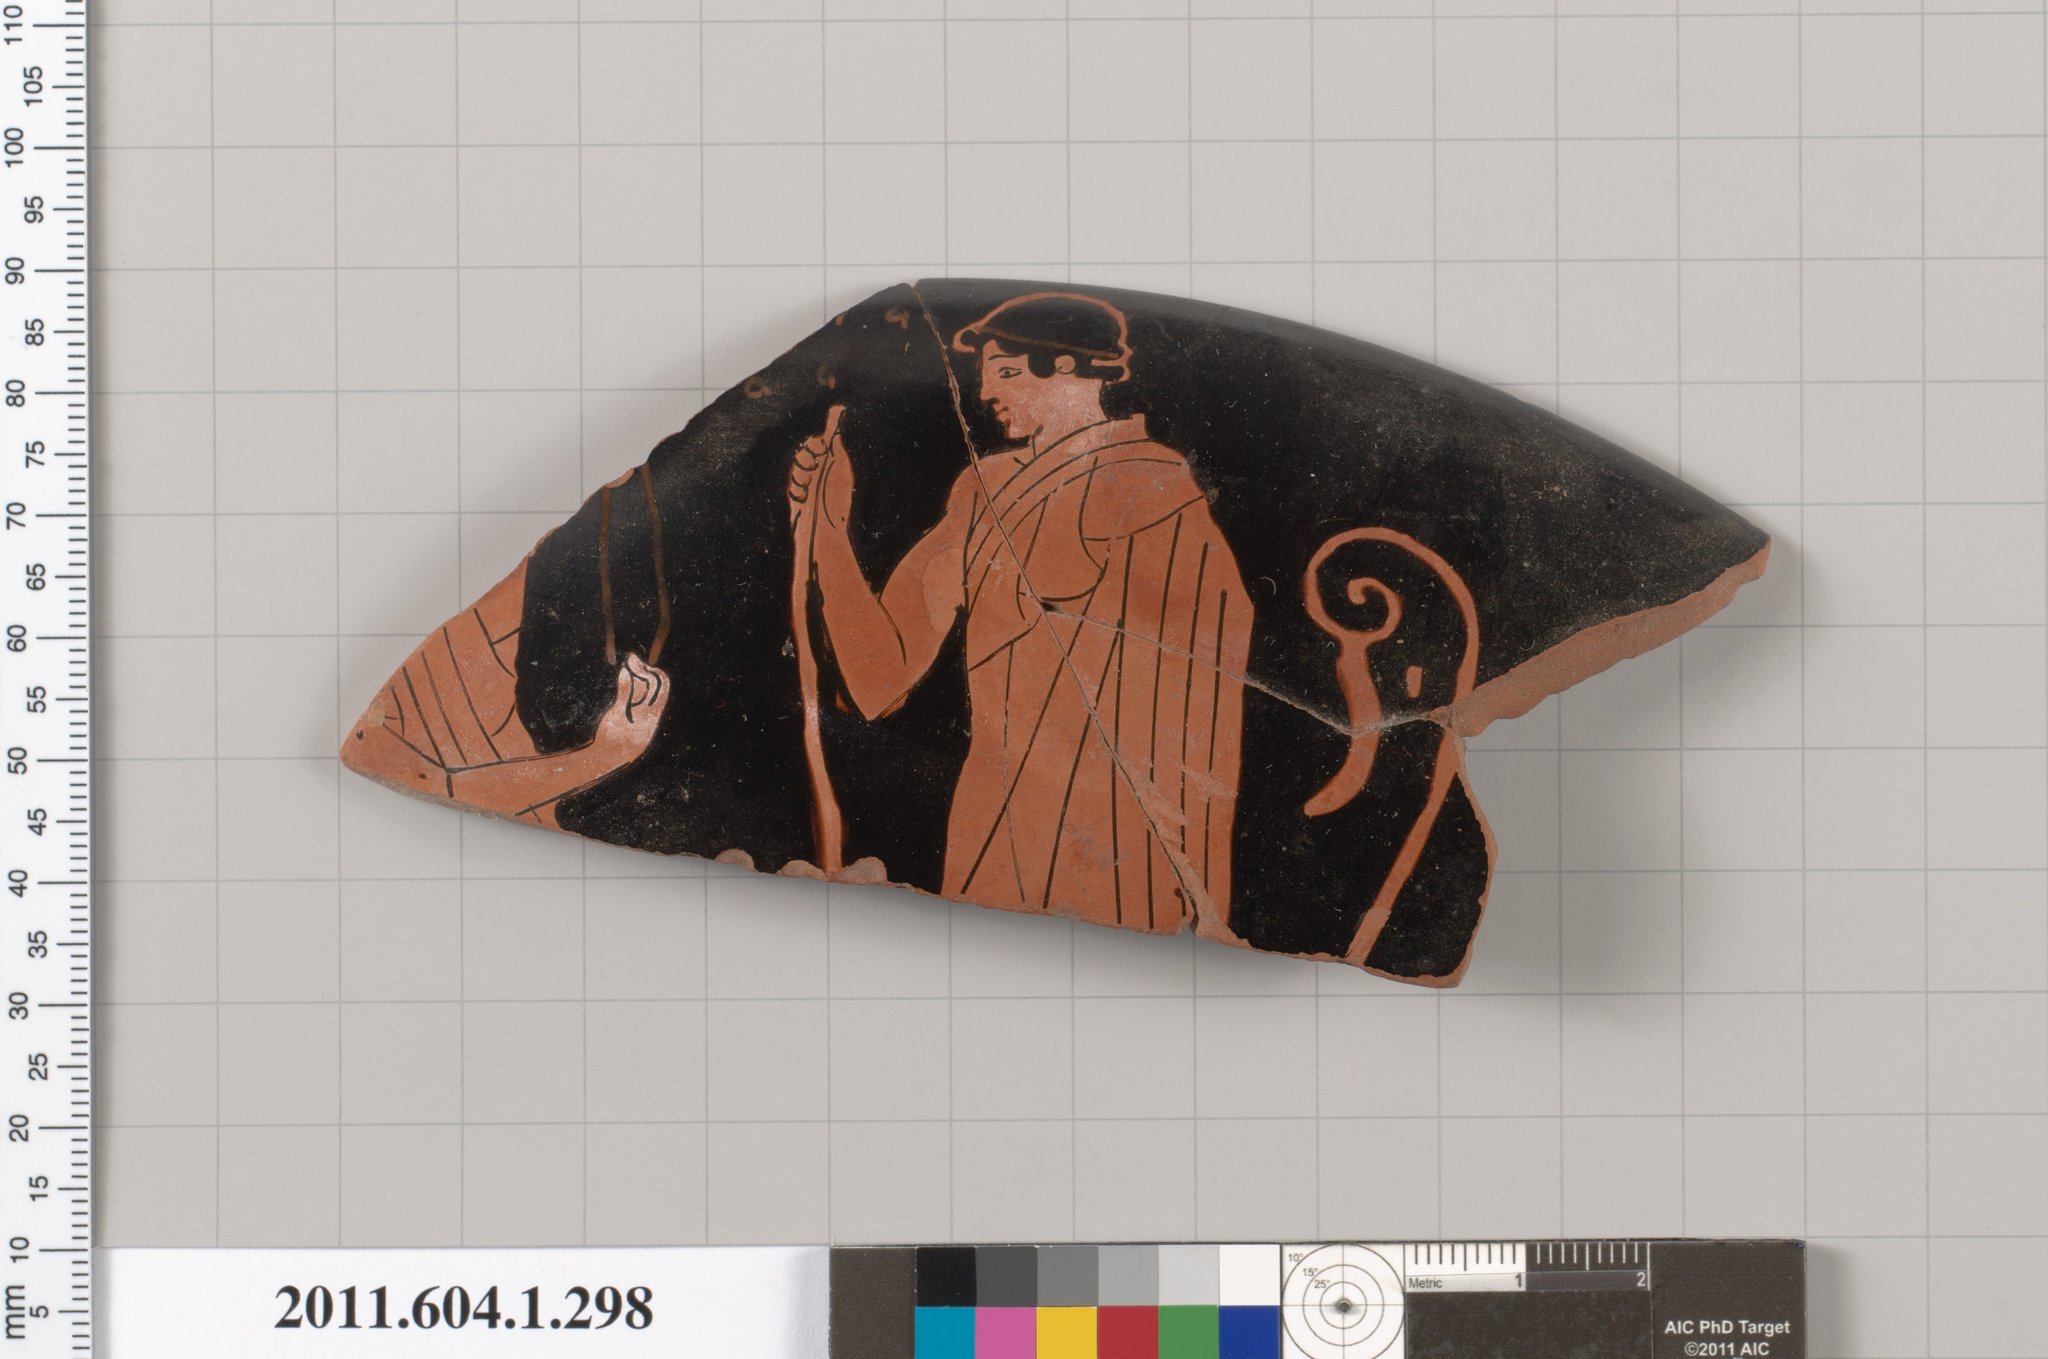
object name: kylix fragment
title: Terracotta fragment of a kylix (drinking cup)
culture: greek, attic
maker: painter z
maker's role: artist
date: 475-451 BCE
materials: terracotta